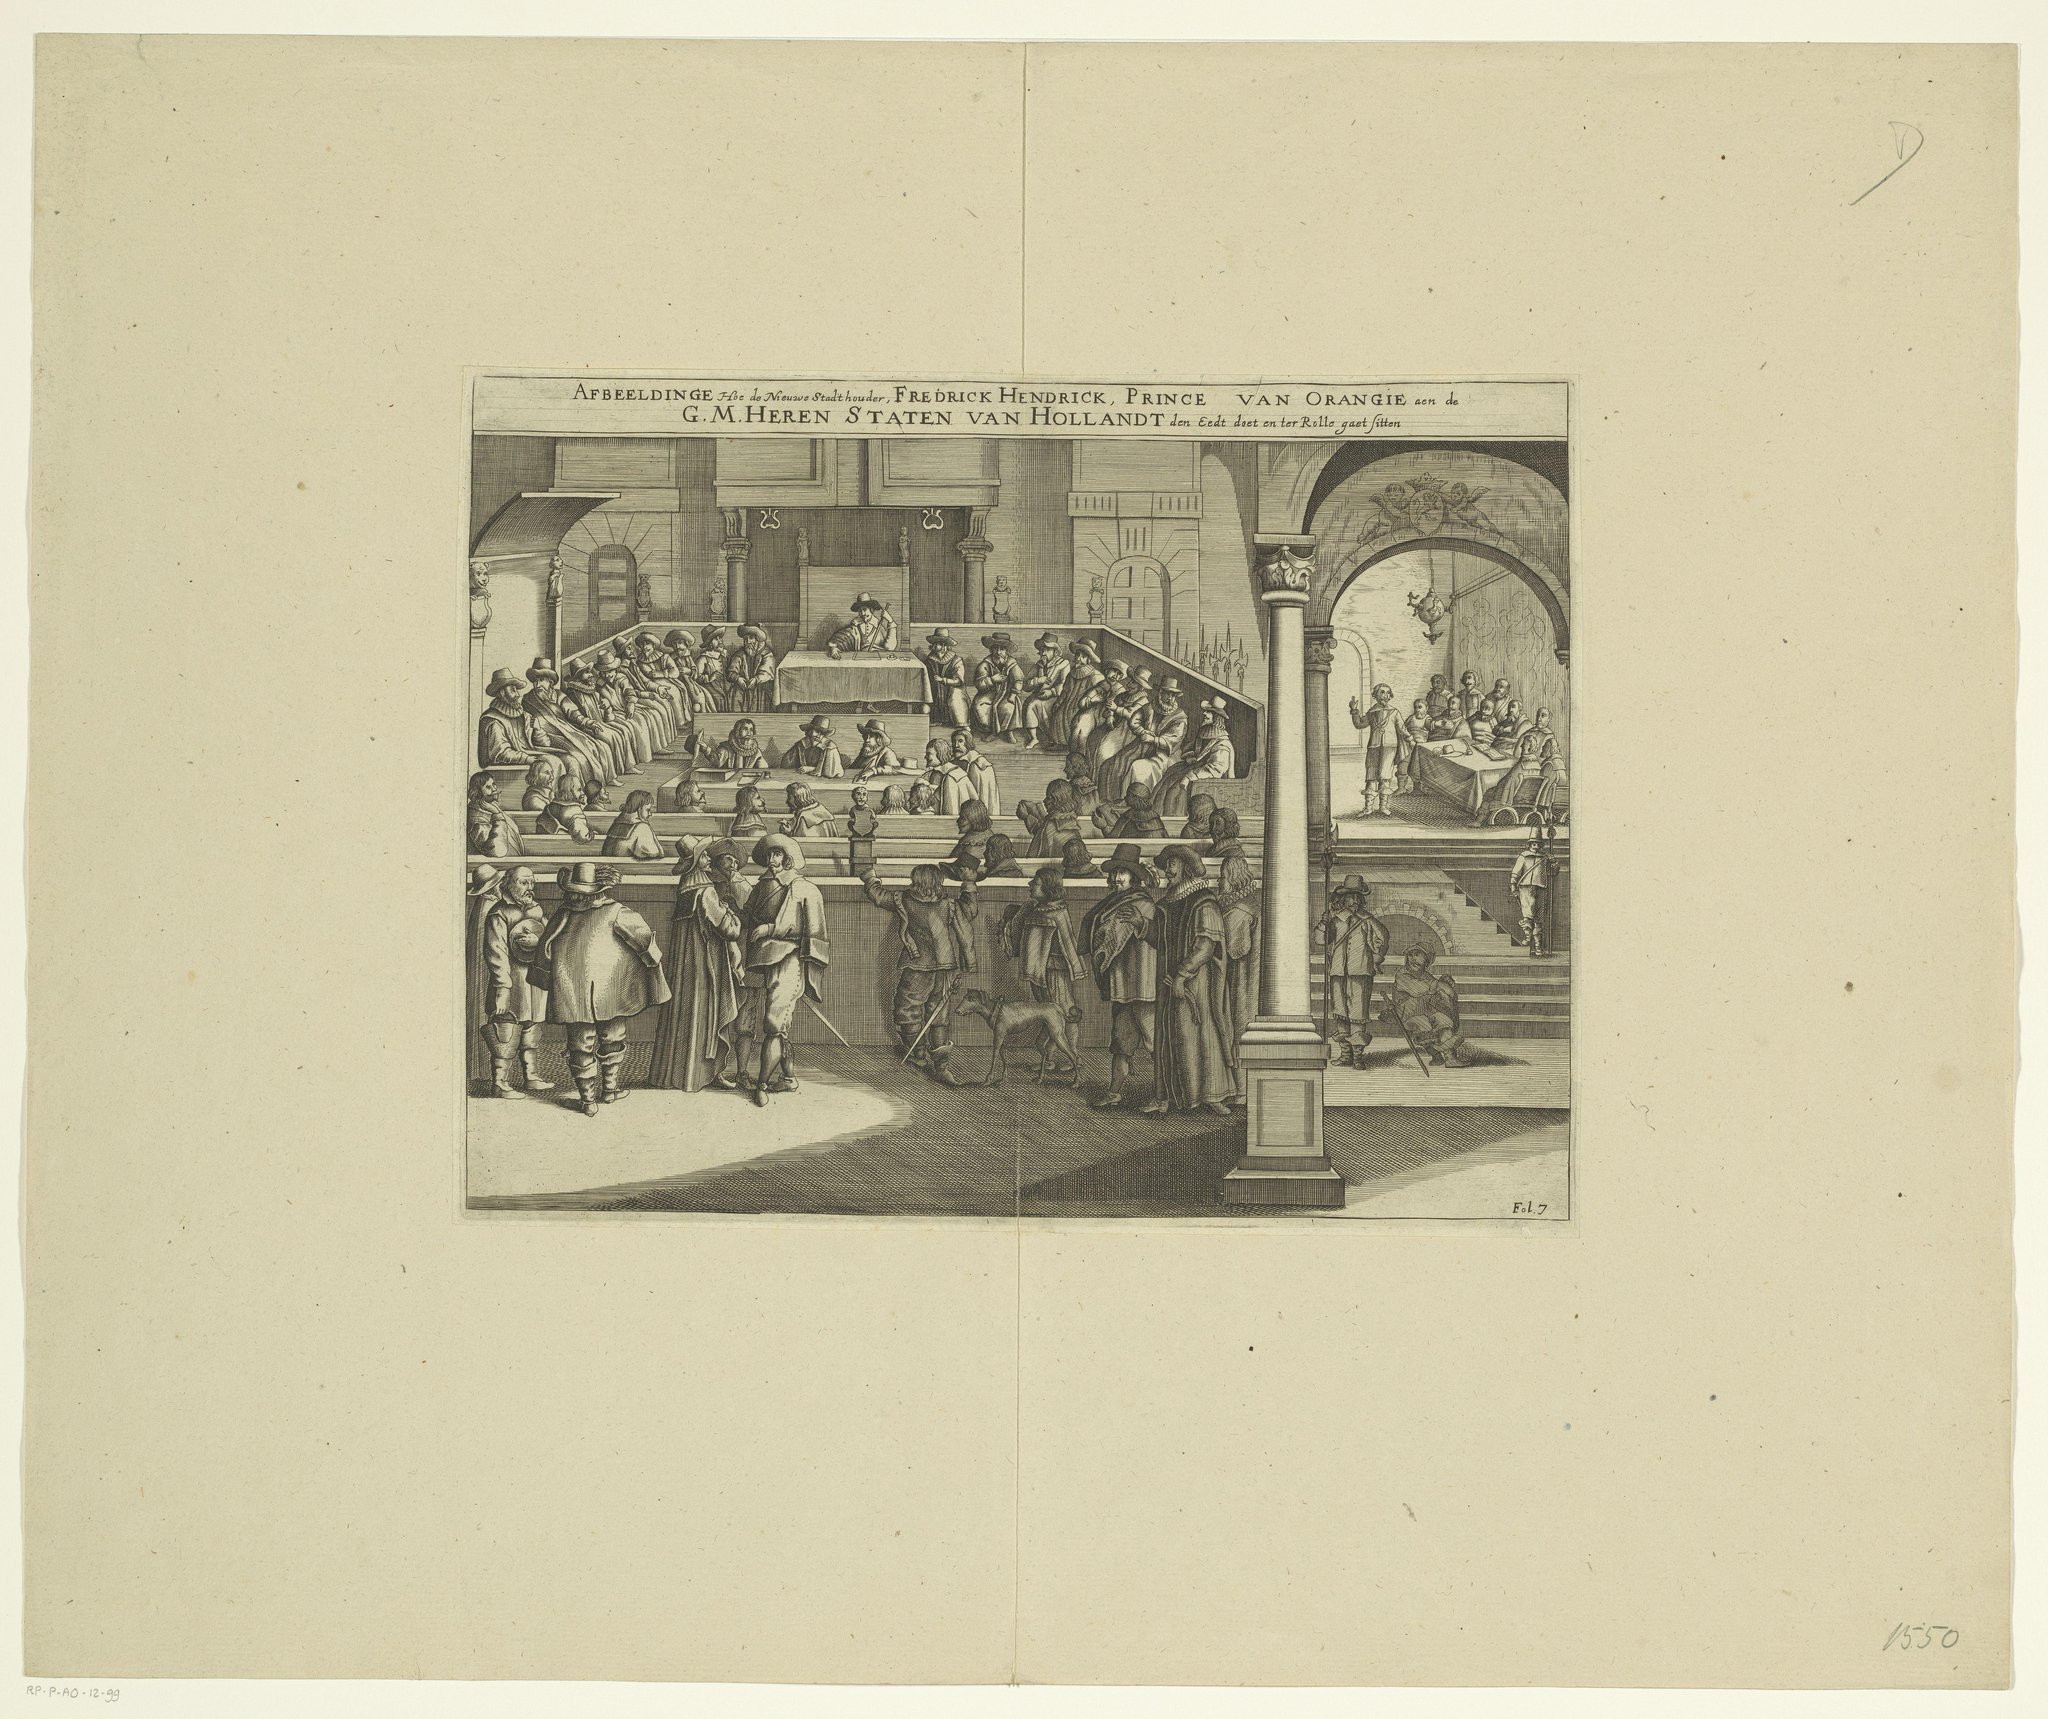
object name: print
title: Afbeeldinge hoe de nieuwe stadthouder, Fredrick Hendrick, prince van Orangie aen de G.M. Heren Staten van Hollandt den eedt doet en ter rolle gaet sitten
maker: Anonymous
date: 1651-1652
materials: paper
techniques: engraving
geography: northern netherlands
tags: frederick henry (prince of orange), new ruler taking the oath, popular representation ~ government, the hague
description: Prent gebruikt in: Commelin, I. Frederick Hendrick van Nassauw, prince van Orangien: zyn leven en bedryf. 2 delen. Utrecht: weduwe Esdras Willemsz Snellaert en Gerrit Nieuwenhuysen, dl. 1, tussen p. 6 en 7. Spiegelbeeldige kopie naar de prent in de uitgave van Jodocus Janssonius van 1651 (FMH 1549, zie RP-P-OB-81.122).